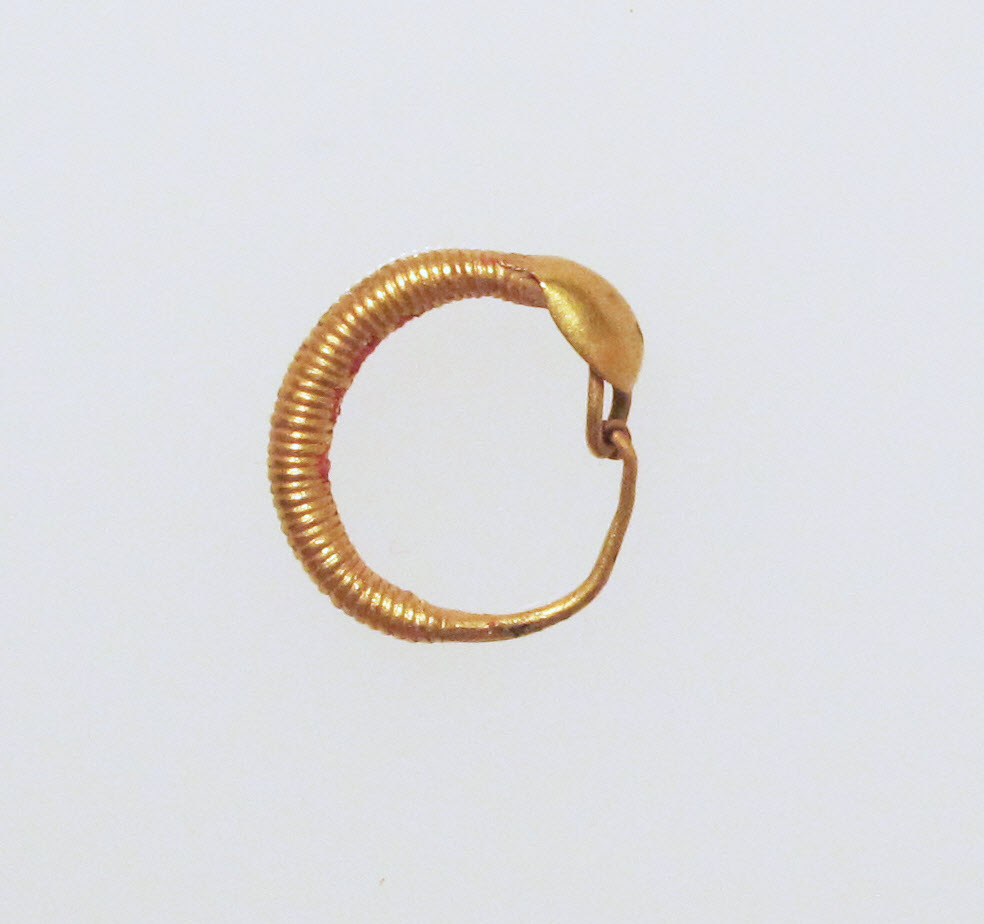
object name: earring with plain loop and disc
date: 7000 BCE-330 CE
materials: gold